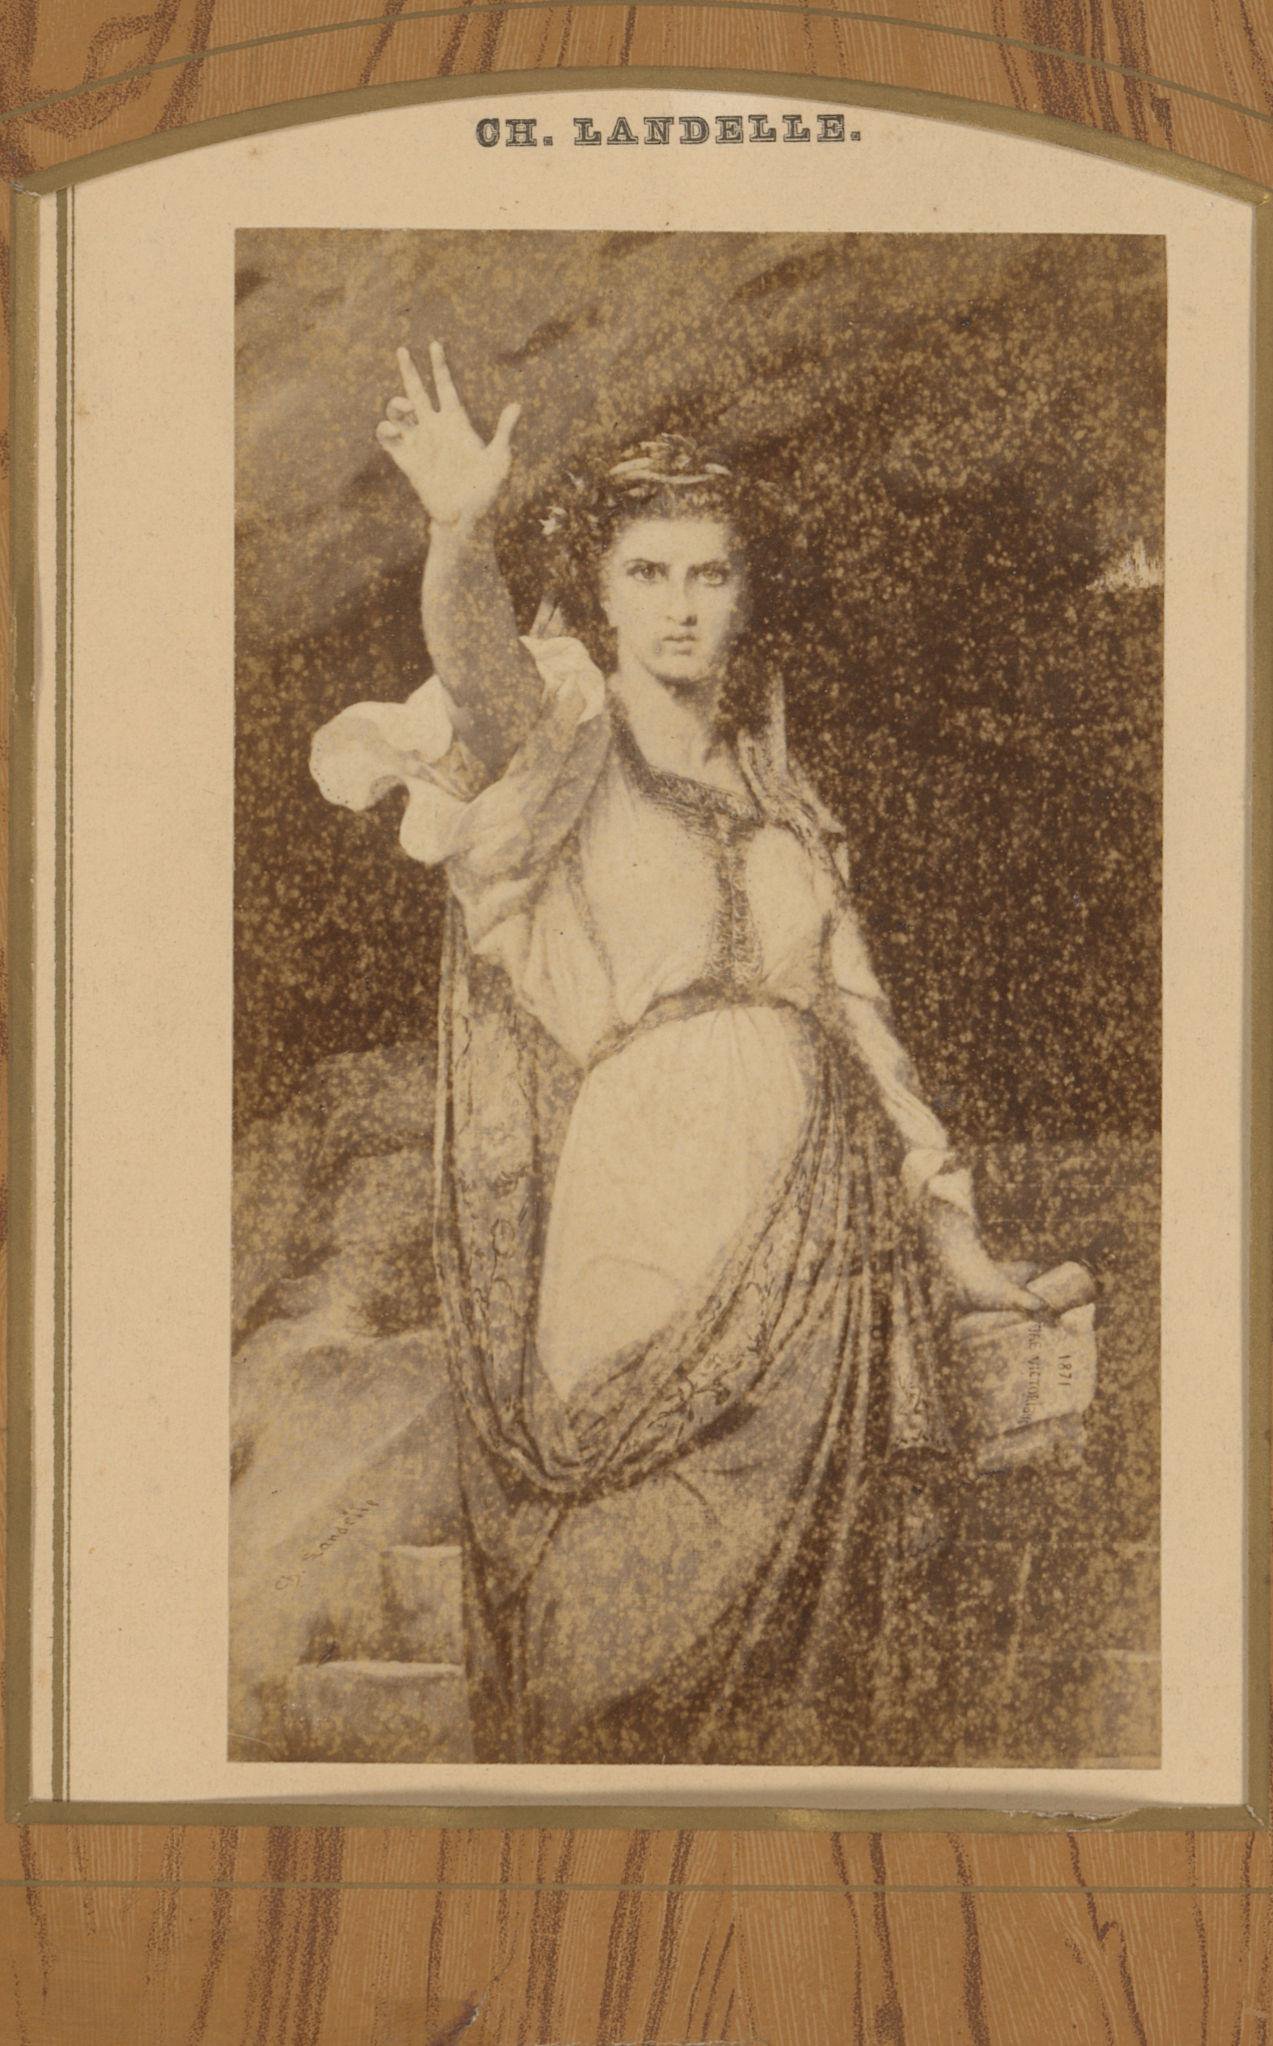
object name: cabinet photograph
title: Velléda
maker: charles landelle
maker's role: painter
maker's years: 1821-1908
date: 1850-1884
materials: cardboard, photographic support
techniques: albumen print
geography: paris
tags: adult woman, seer, prophet ~ roman religion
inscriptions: inscription: ‘Carte-Album No 130’